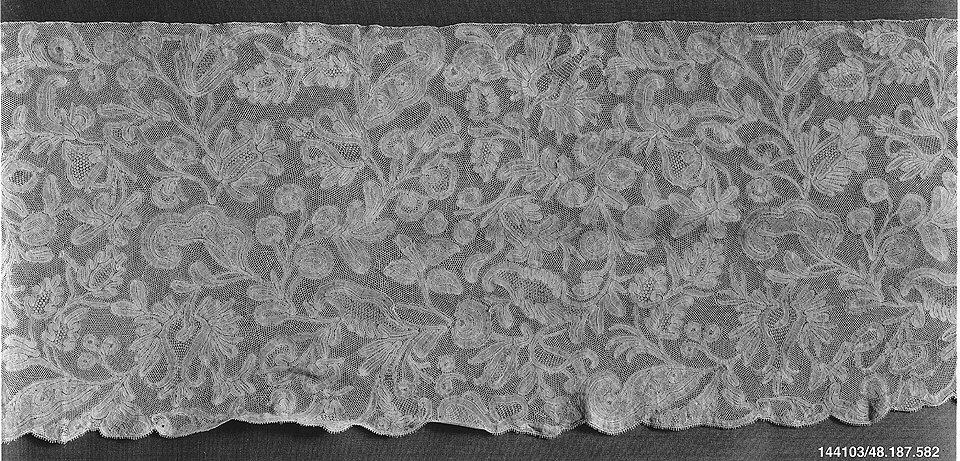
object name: flounce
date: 1667-1733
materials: lace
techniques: lace